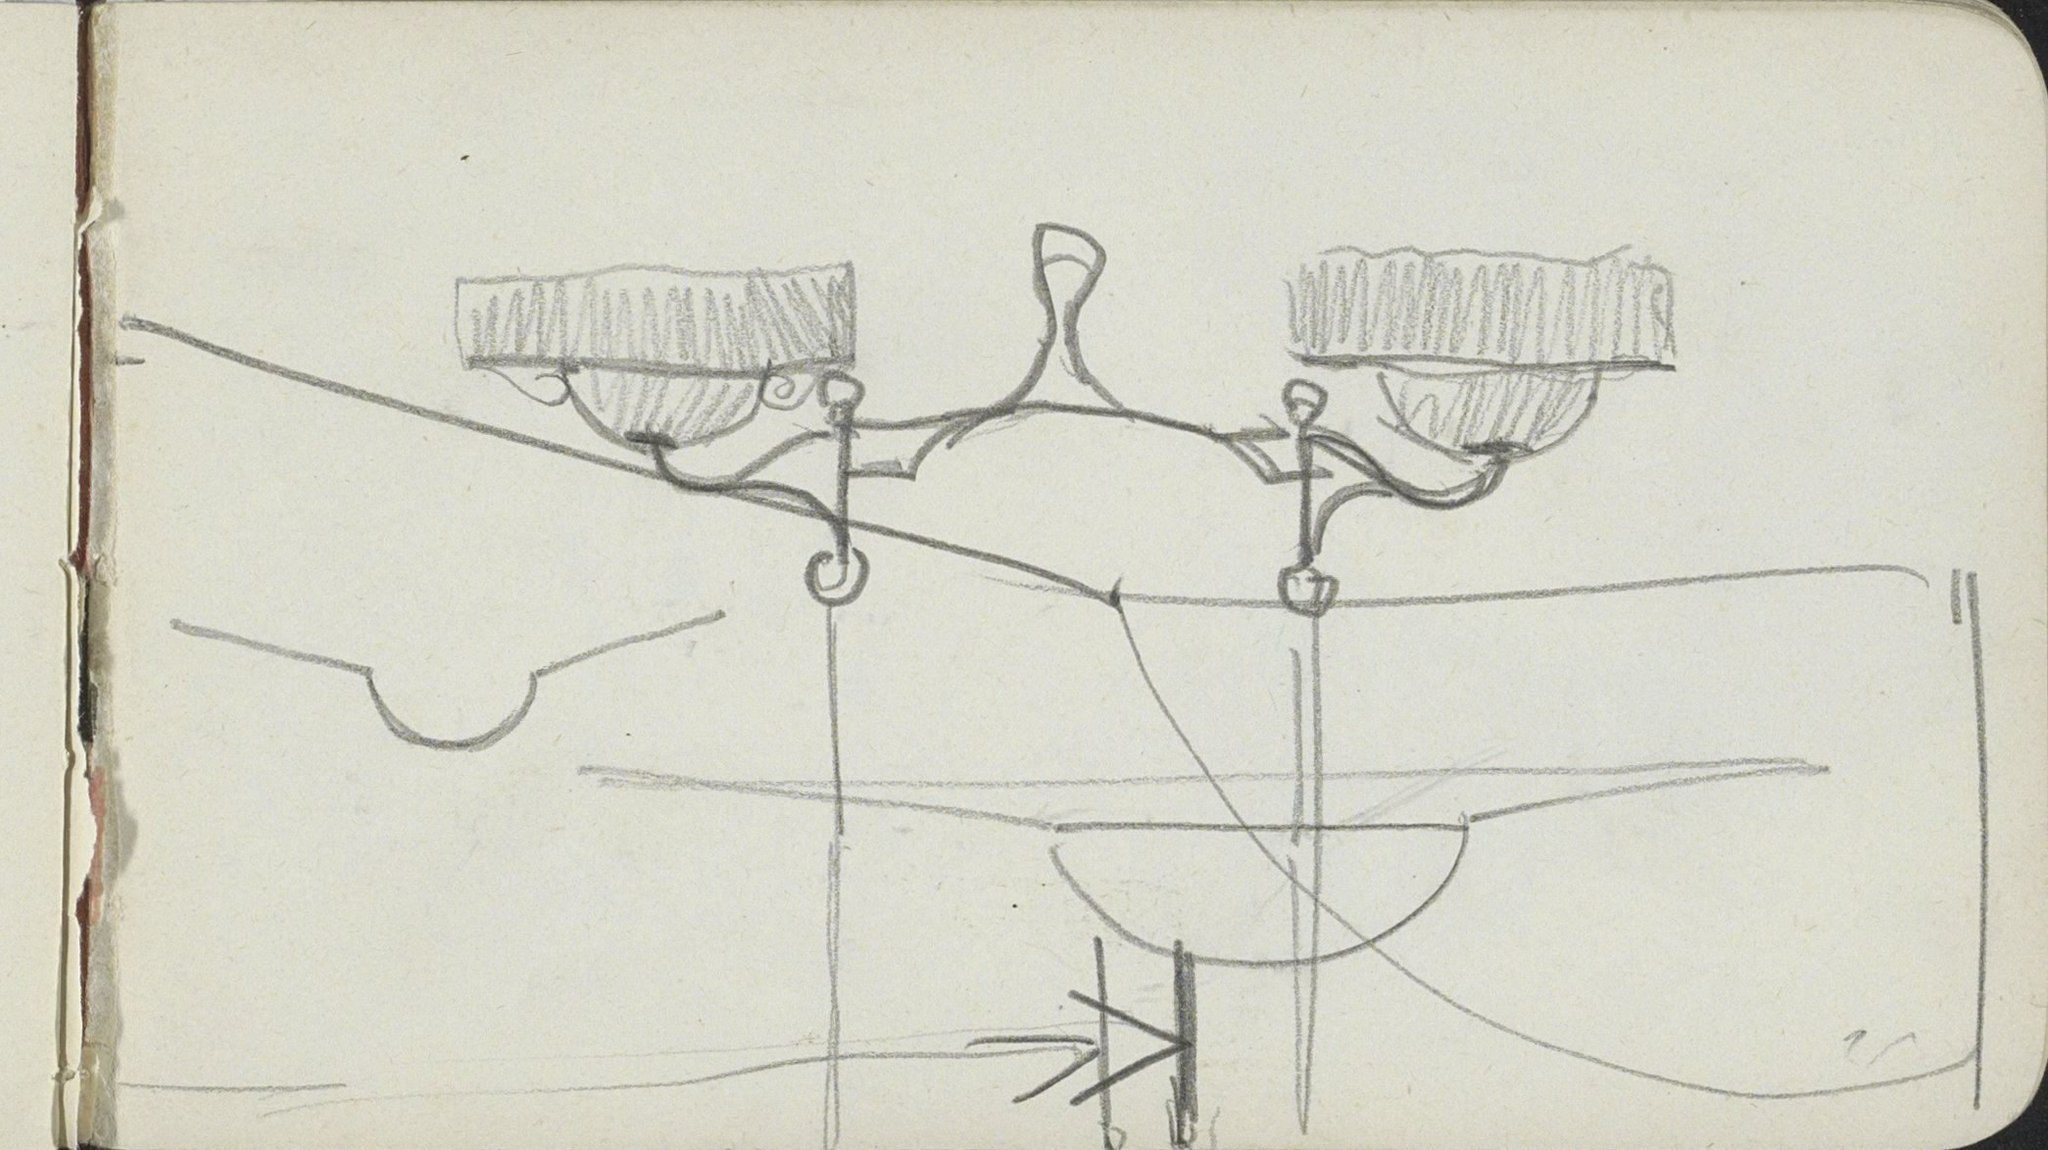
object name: sketchbook leaf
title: Hanglamp met twee kappen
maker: carel adolph lion cachet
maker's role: draughtsman, print maker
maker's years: 1864-1945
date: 1905-1906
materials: paper, pencil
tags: lighting; lamps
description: Blad 18 recto uit een schetsboek met 34 bladen.